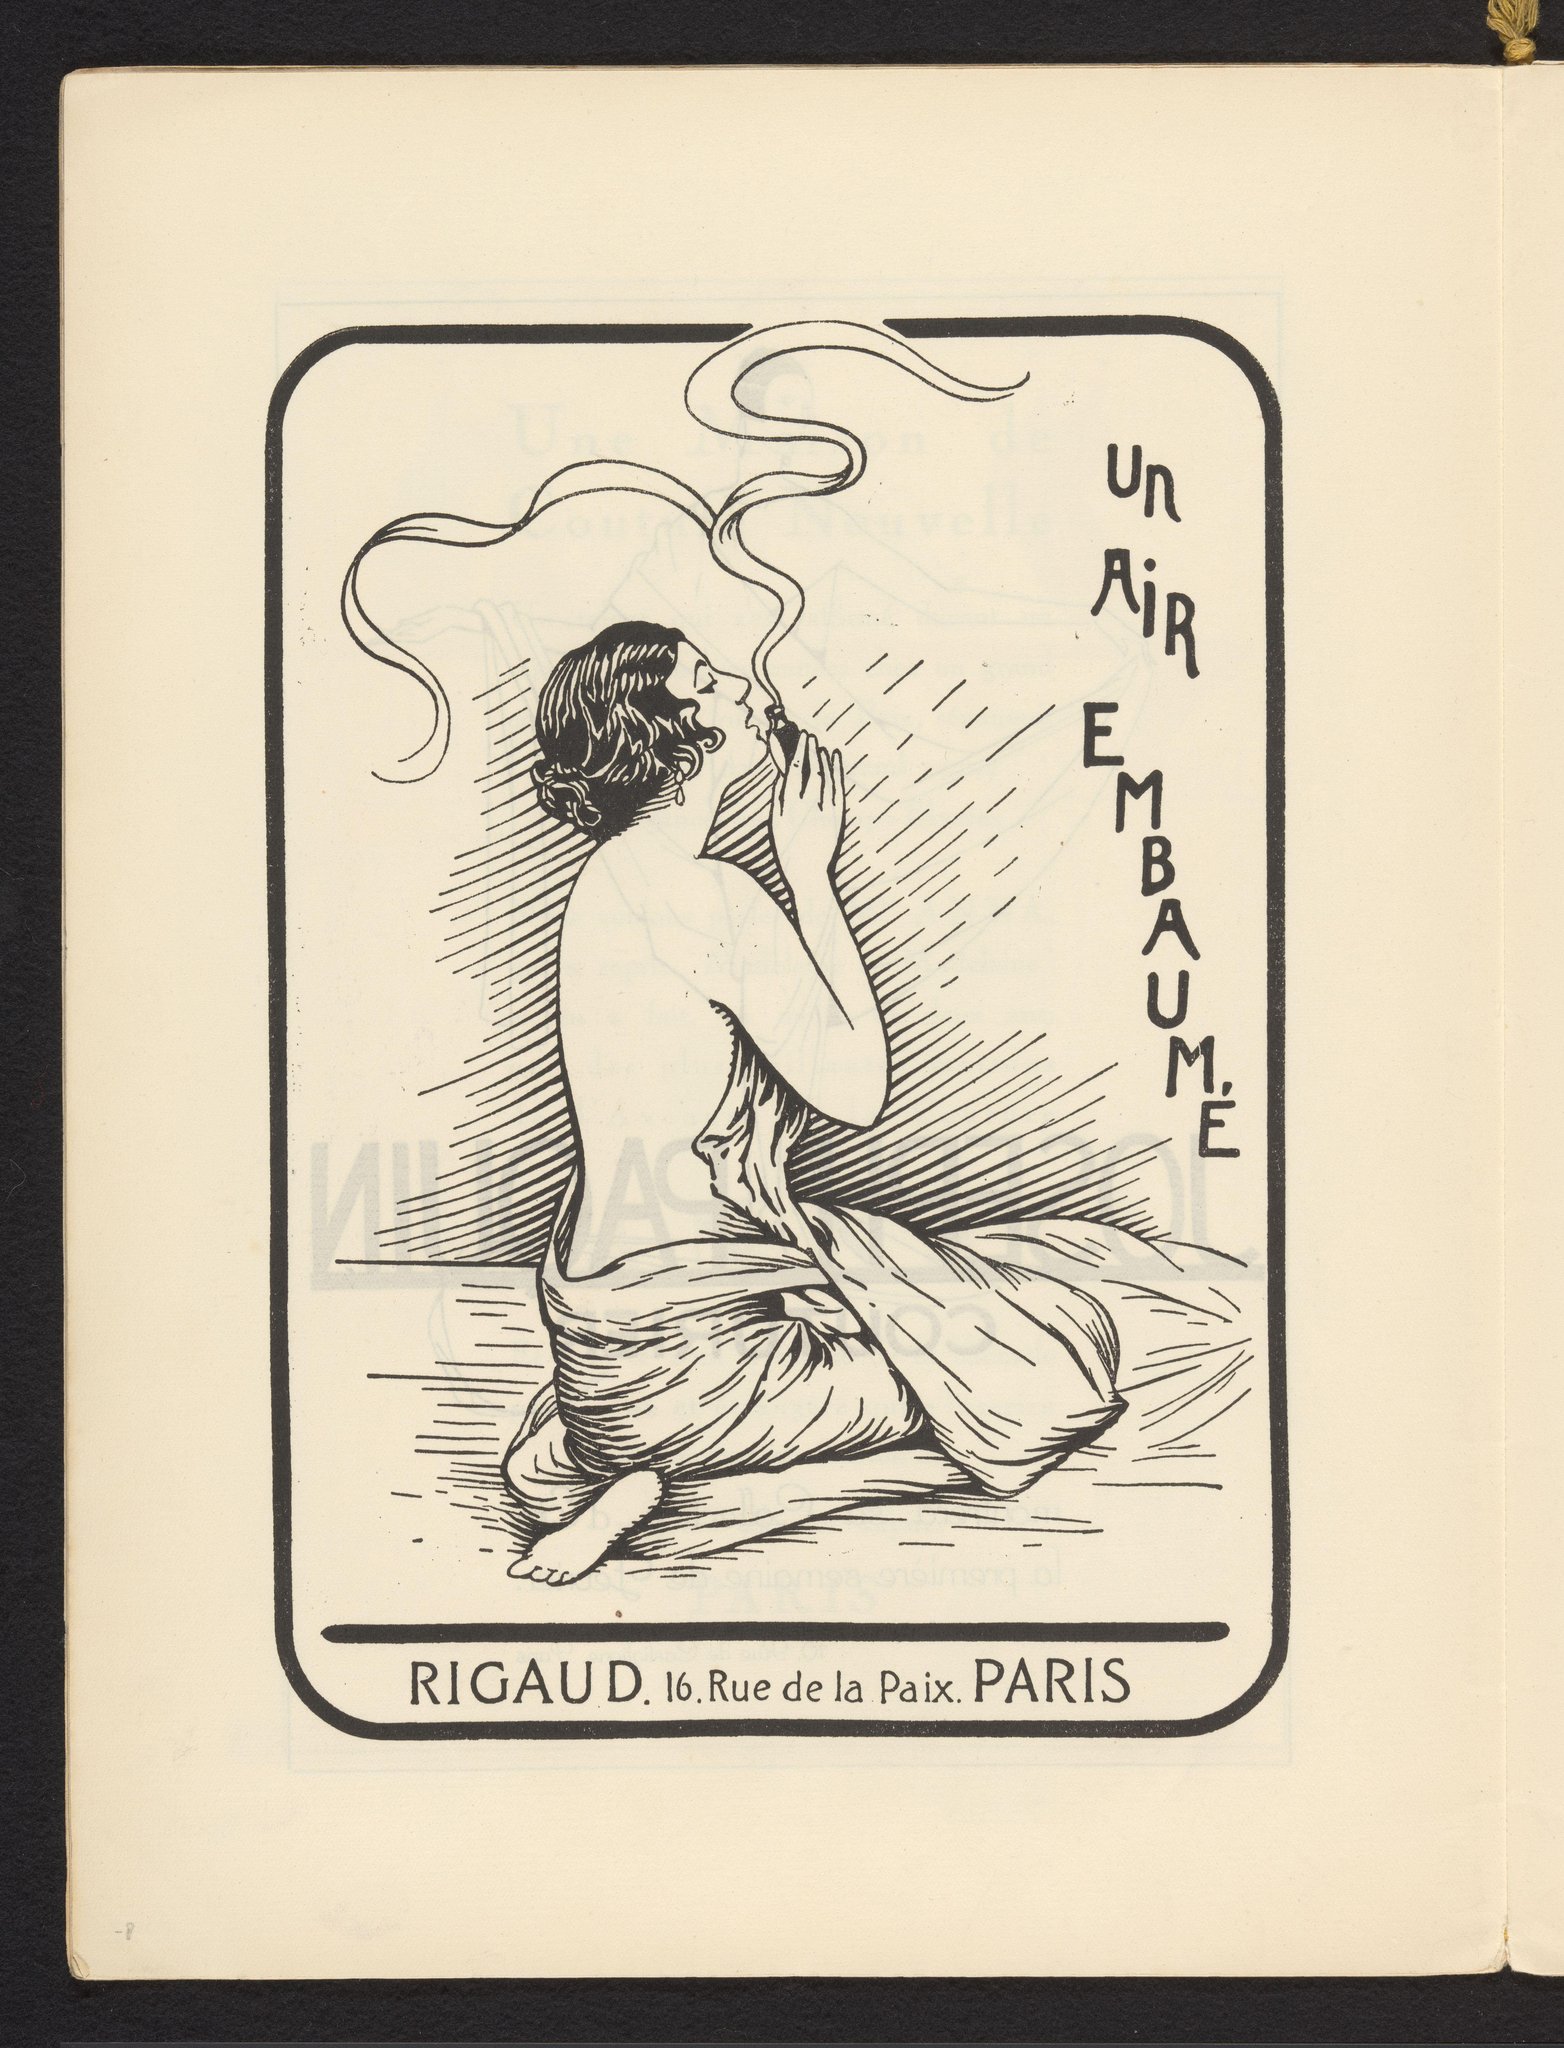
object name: magazine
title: Art - Goût - Beauté, Feuillets de l' élégance féminine, Février 1926, No. 66, 6e Année, p. 8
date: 1926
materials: paper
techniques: lithograph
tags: perfume bottle - aa - (for) women, fashion plates, smell, smelling (one of the five senses) - aa - female human figure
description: Advertentie voor parfum van Rigaud. Pagina uit het modetijdschrift Art-Goût-Beauté (1920-1933).